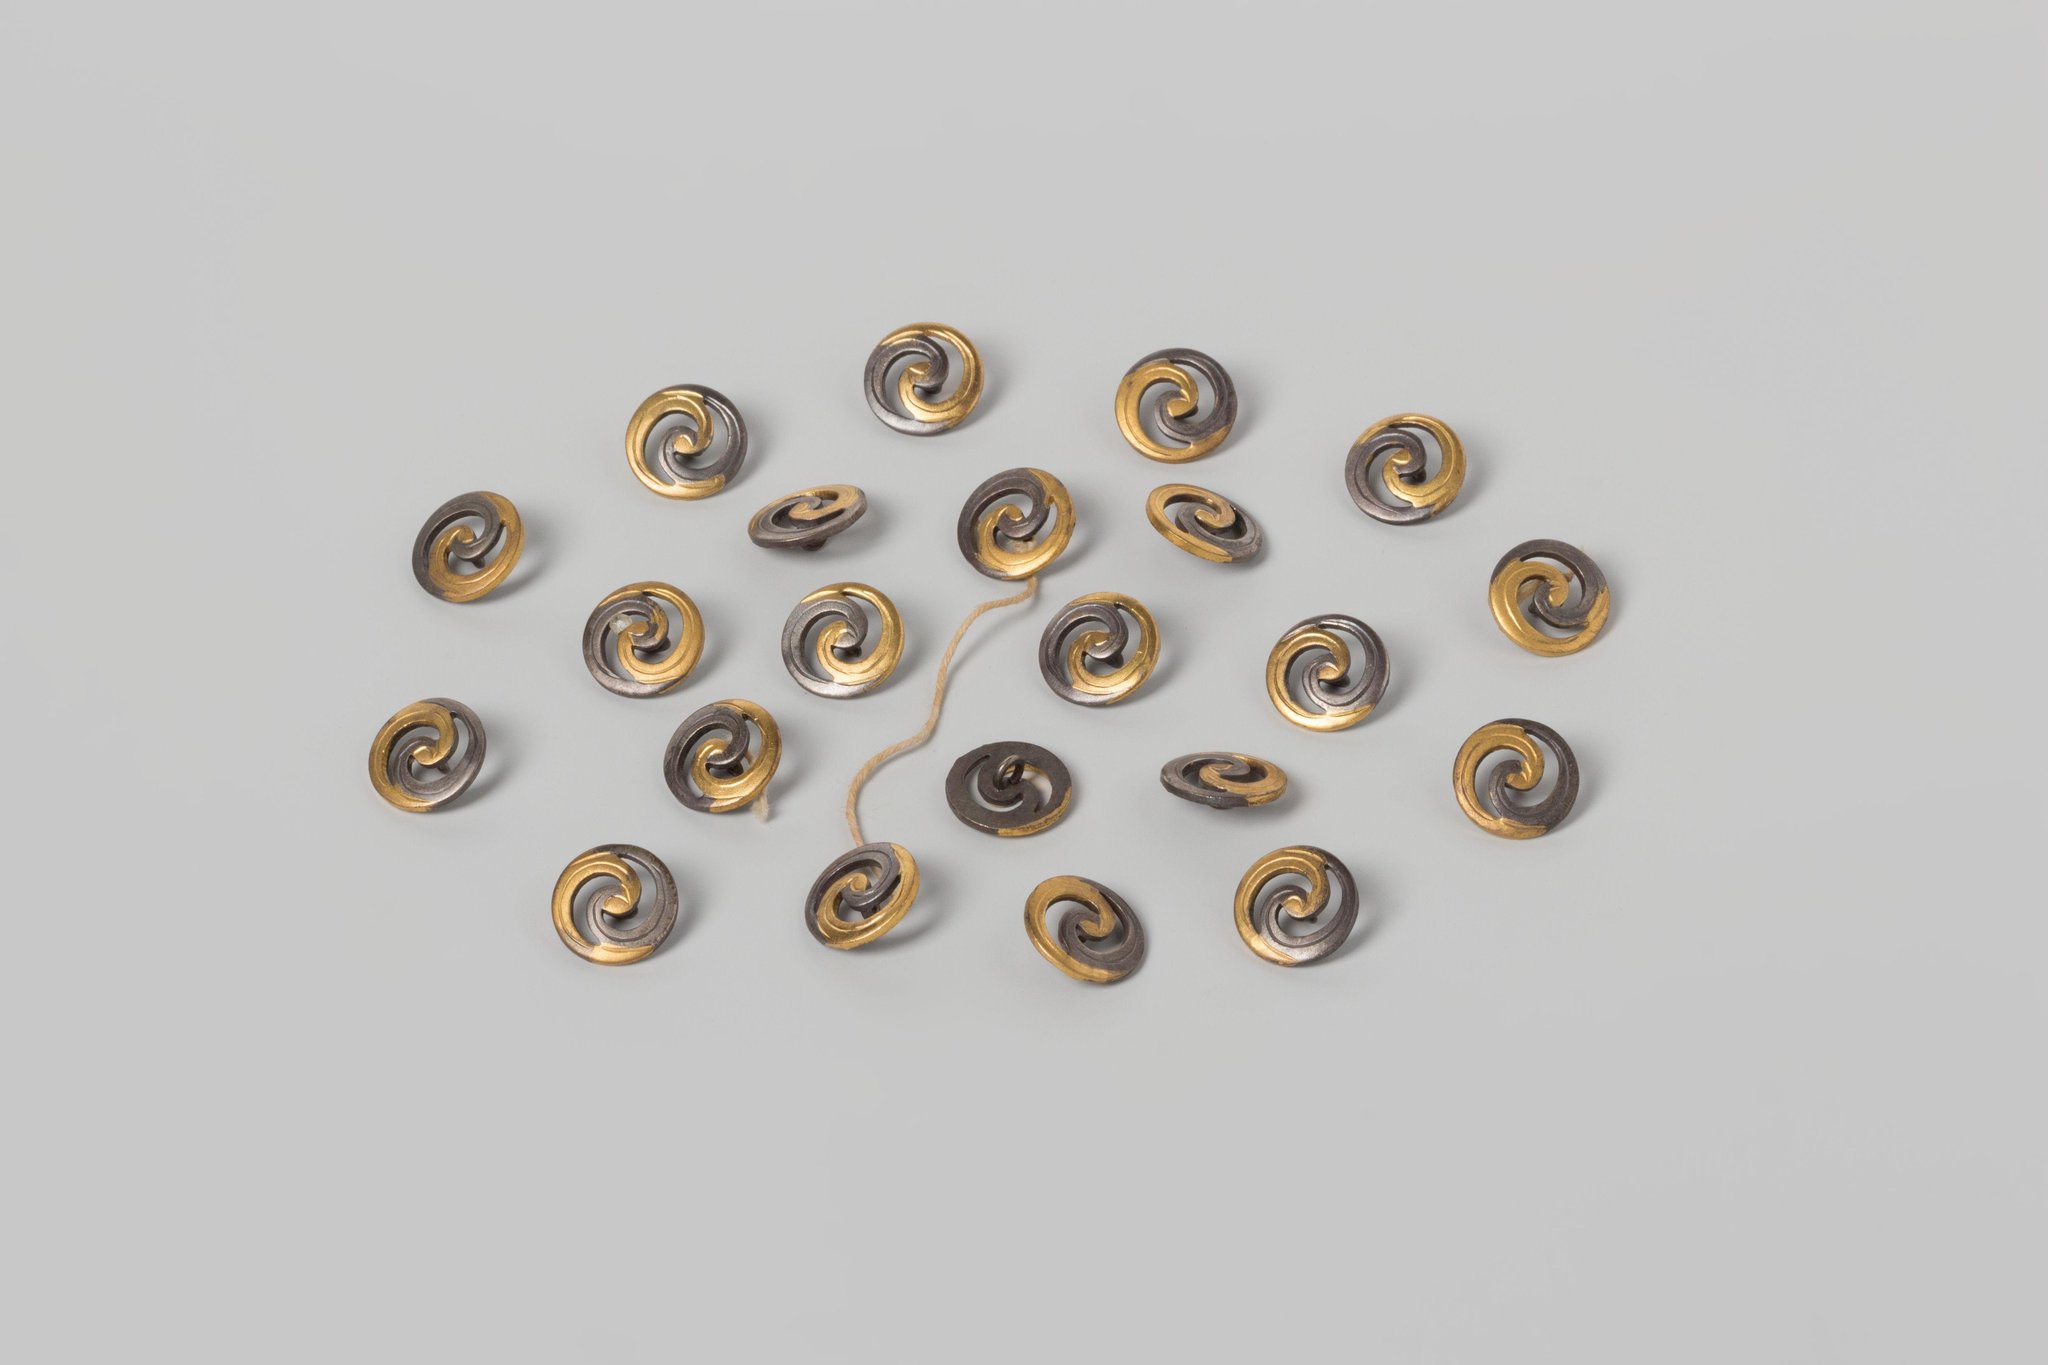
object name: clothing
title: Knoop, plat en rond, van gedeeltelijk met goudverf beschilderd metaal met krulmotief, gelijkend yin en yang, opengewerkt en gegraveerd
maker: Anonymous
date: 1880-1940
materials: paint, metal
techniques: embroidery, engraving, painting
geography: europe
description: Knoop, plat en rond, van gedeeltelijk met goudverf beschilderd metaal met krulmotief, gelijkend yin en yang, opengewerkt en gegraveerd.